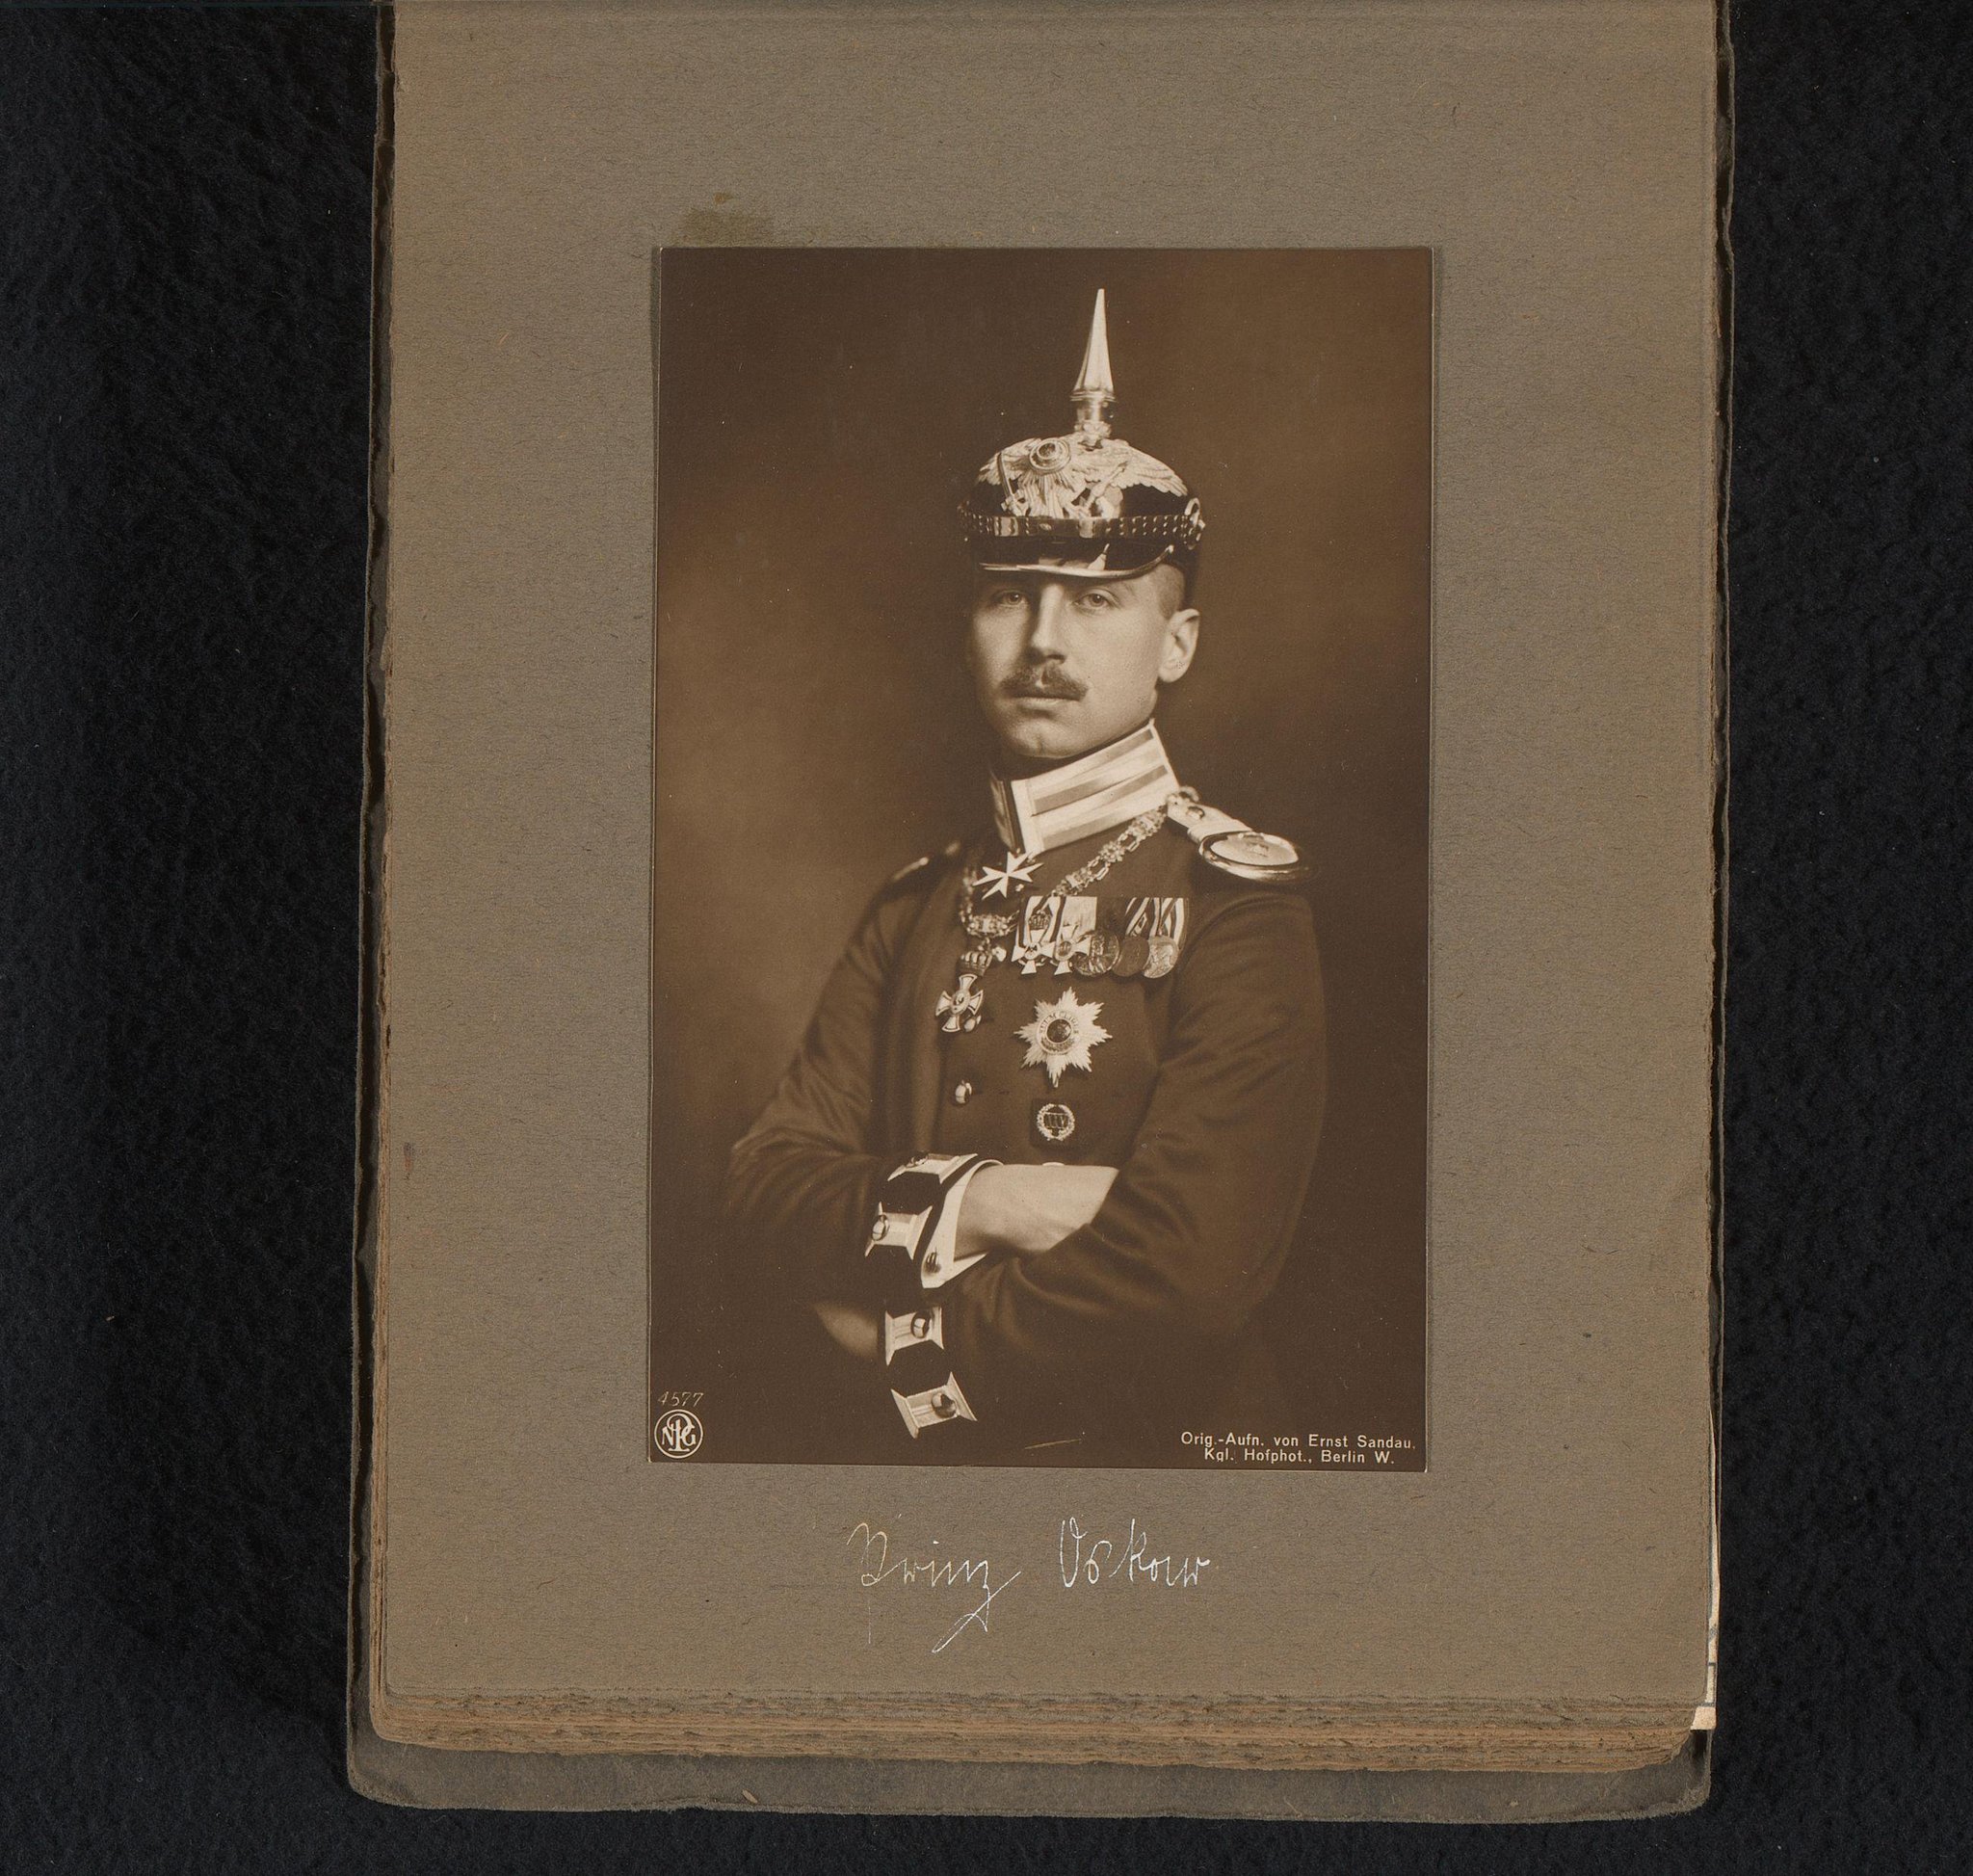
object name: photograph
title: Portret van Oscar van Pruisen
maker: ernst sandau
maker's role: fotograaf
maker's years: 1880-1918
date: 1910-1913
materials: paper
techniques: gelatin silver print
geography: berlin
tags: prince, historical persons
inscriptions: number: ‘4577’